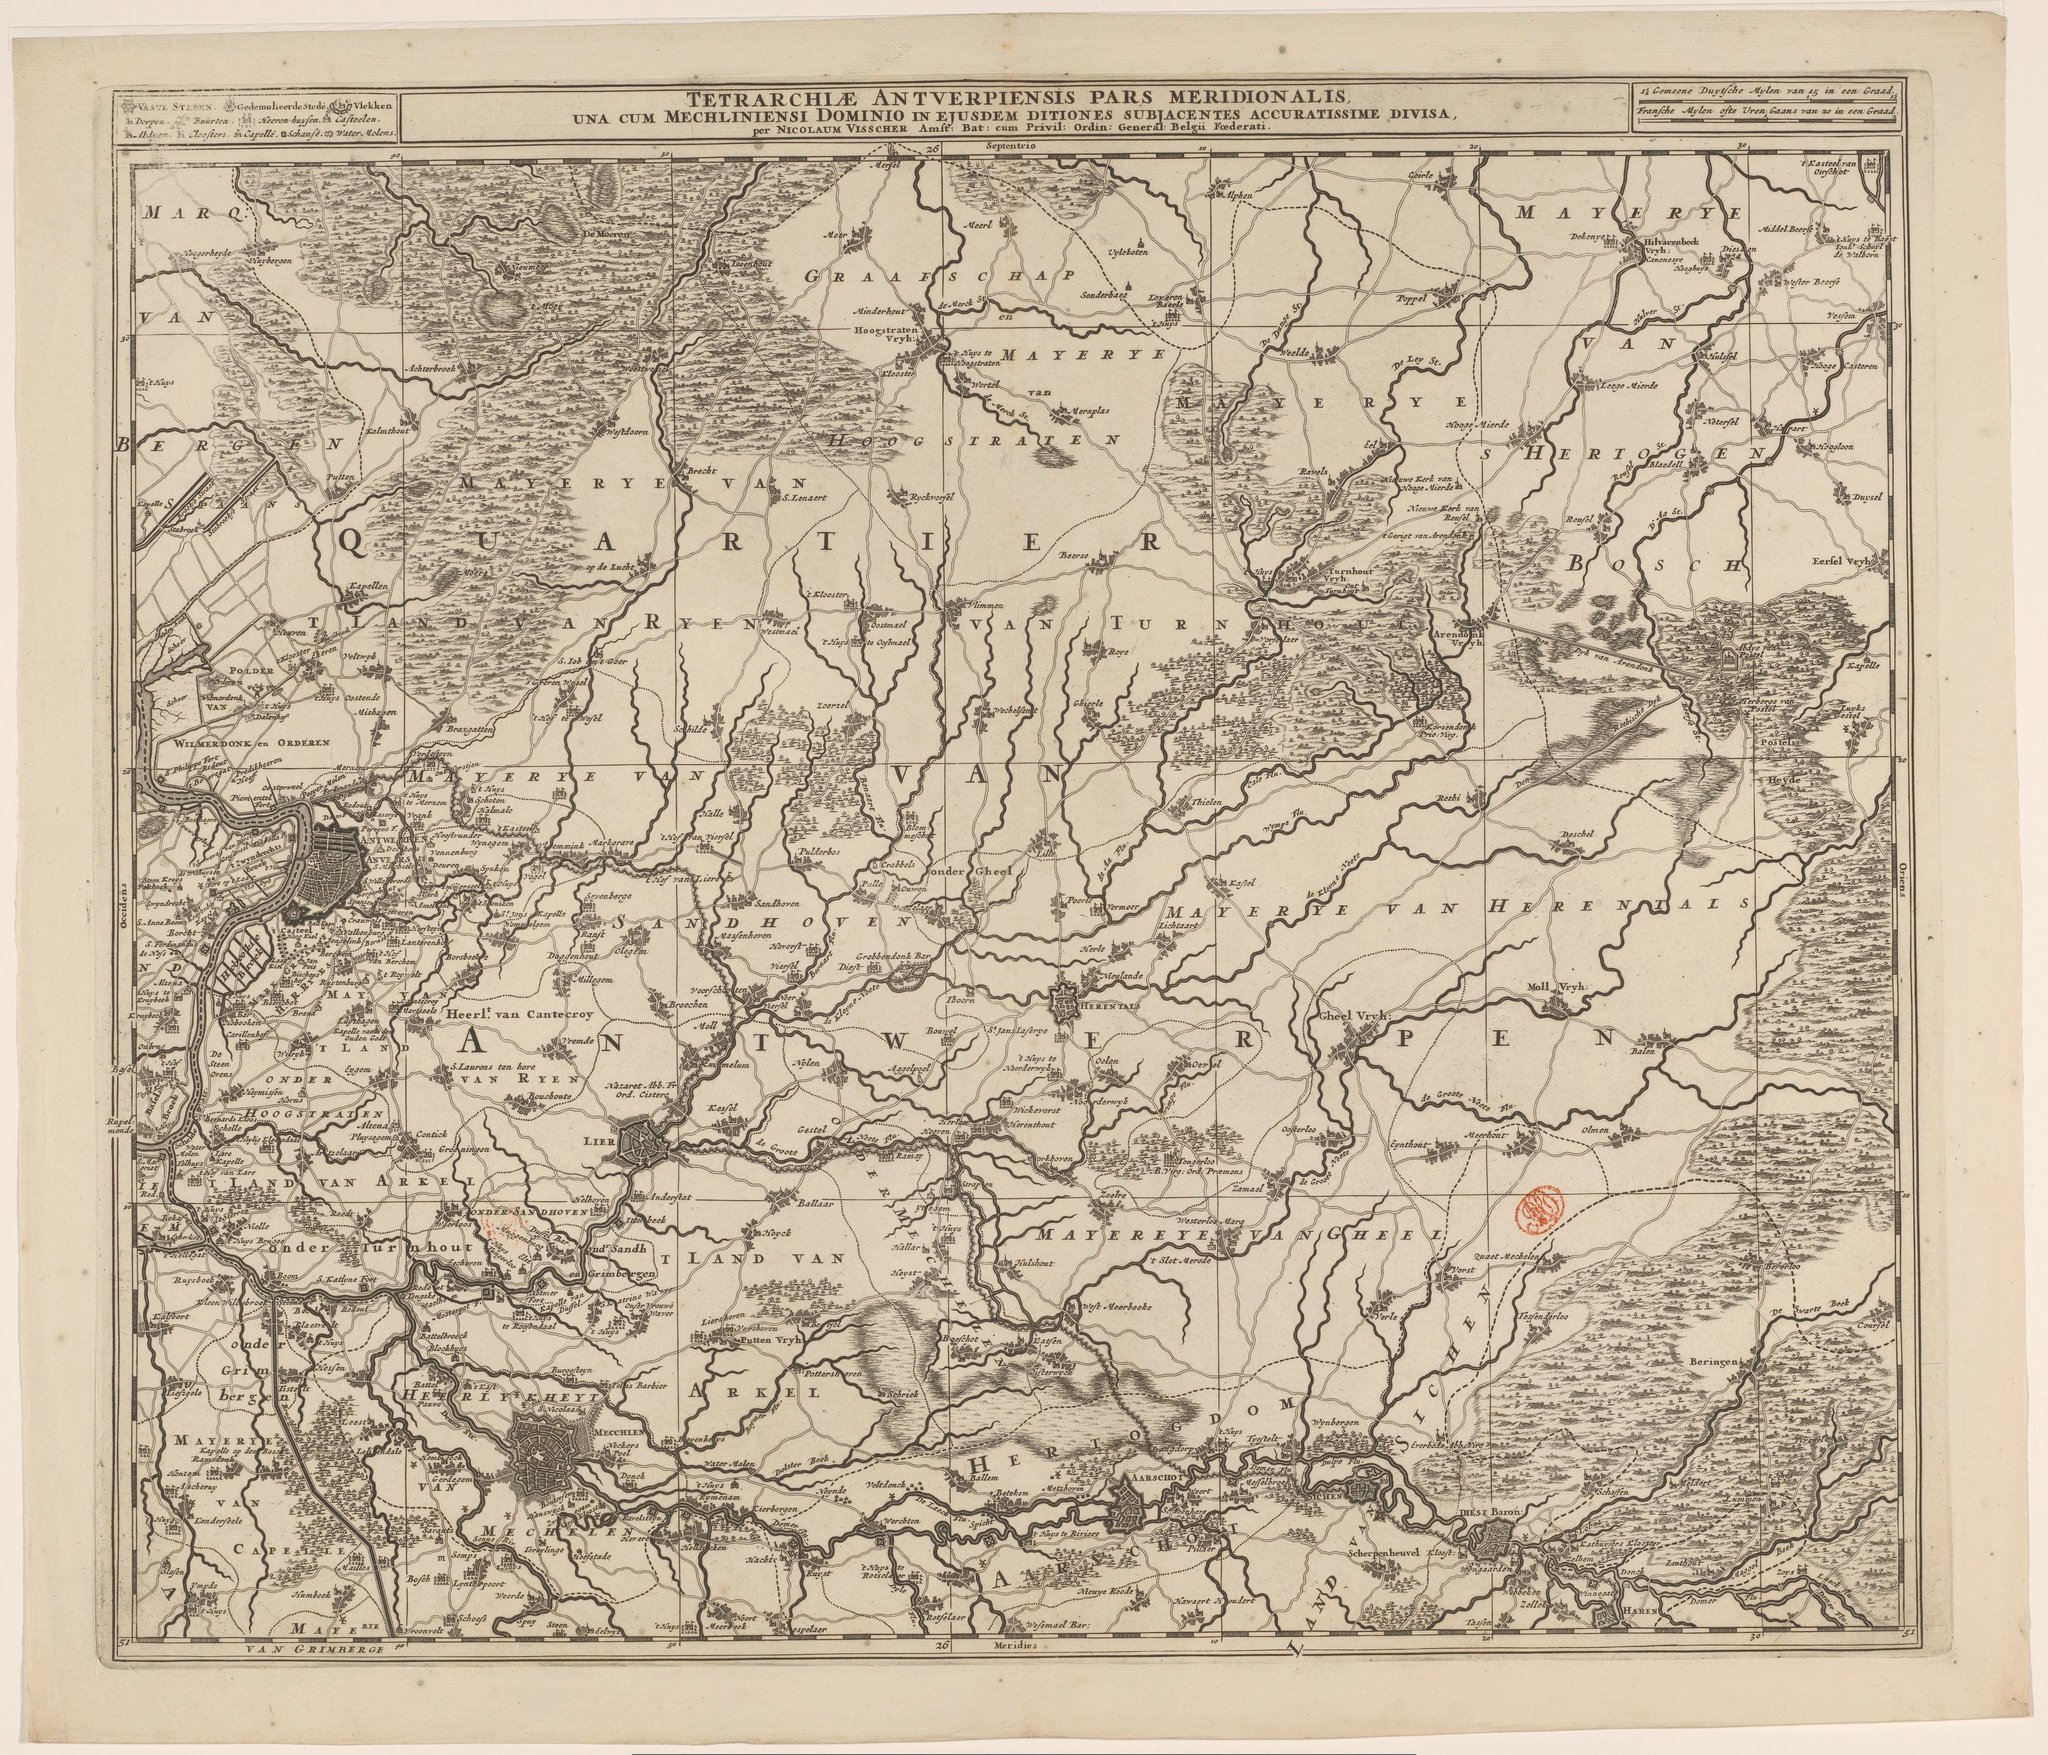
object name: map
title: Kaart van het kwartier van Antwerpen, onderdeel van het hertogdom Brabant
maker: Anonymous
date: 1677-1720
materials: paper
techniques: engraving, etching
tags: maps of separate countries or regions, brabant, antwerp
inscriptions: collector's mark: Lugt 195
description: Kaart van het kwartier van Antwerpen, één van de vier kwartieren waarin het hertogdom Brabant is verdeeld. In een balk boven de kaart, in het midden, de titel. Links hiervan een legenda. Rechts van de titel twee schaalstokken: 1 1/2 Gemeene Duytsche Mijlen van 15 in een Graad / 2 Fransche Mylen ofte Uren Gaans van 20 in een Graad. De kaart is voorzien van een coördinaten-net en een gradenverdeling.